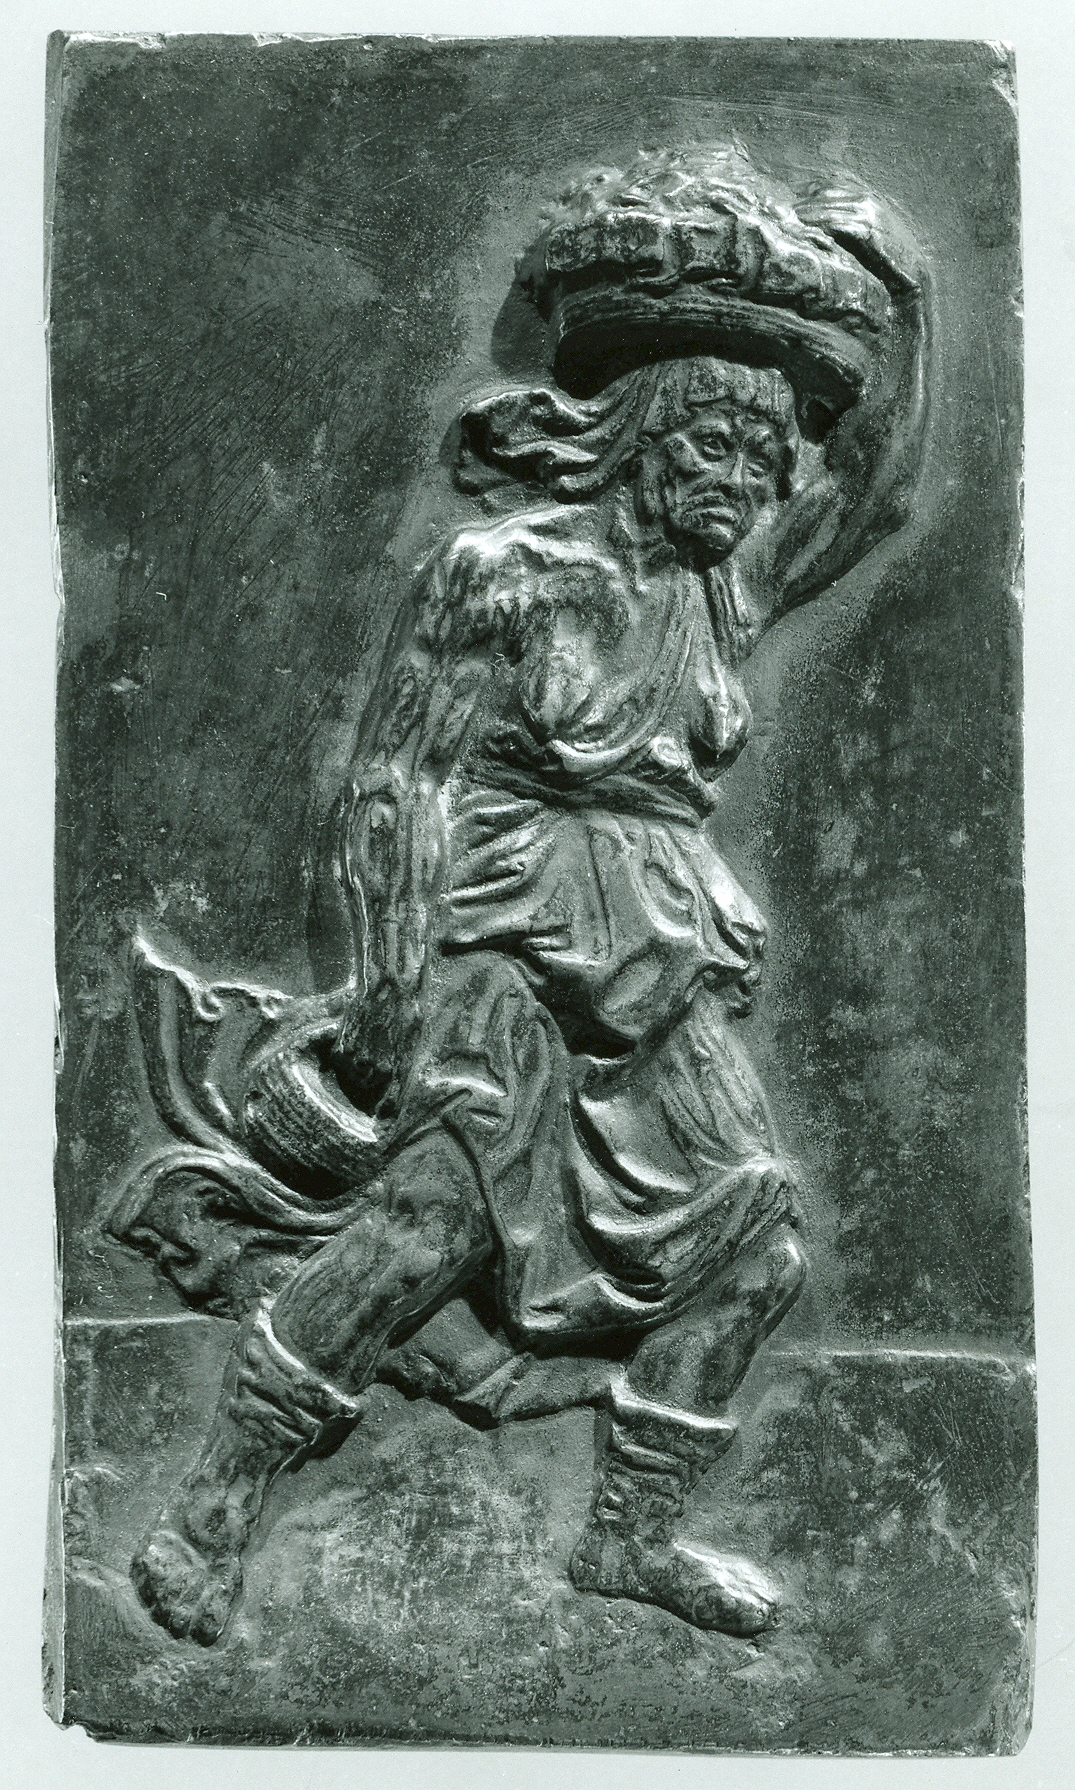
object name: plaquette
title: Old Beggar Woman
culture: italian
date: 1501-1550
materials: copper alloy, lacquer, patina, wax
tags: women